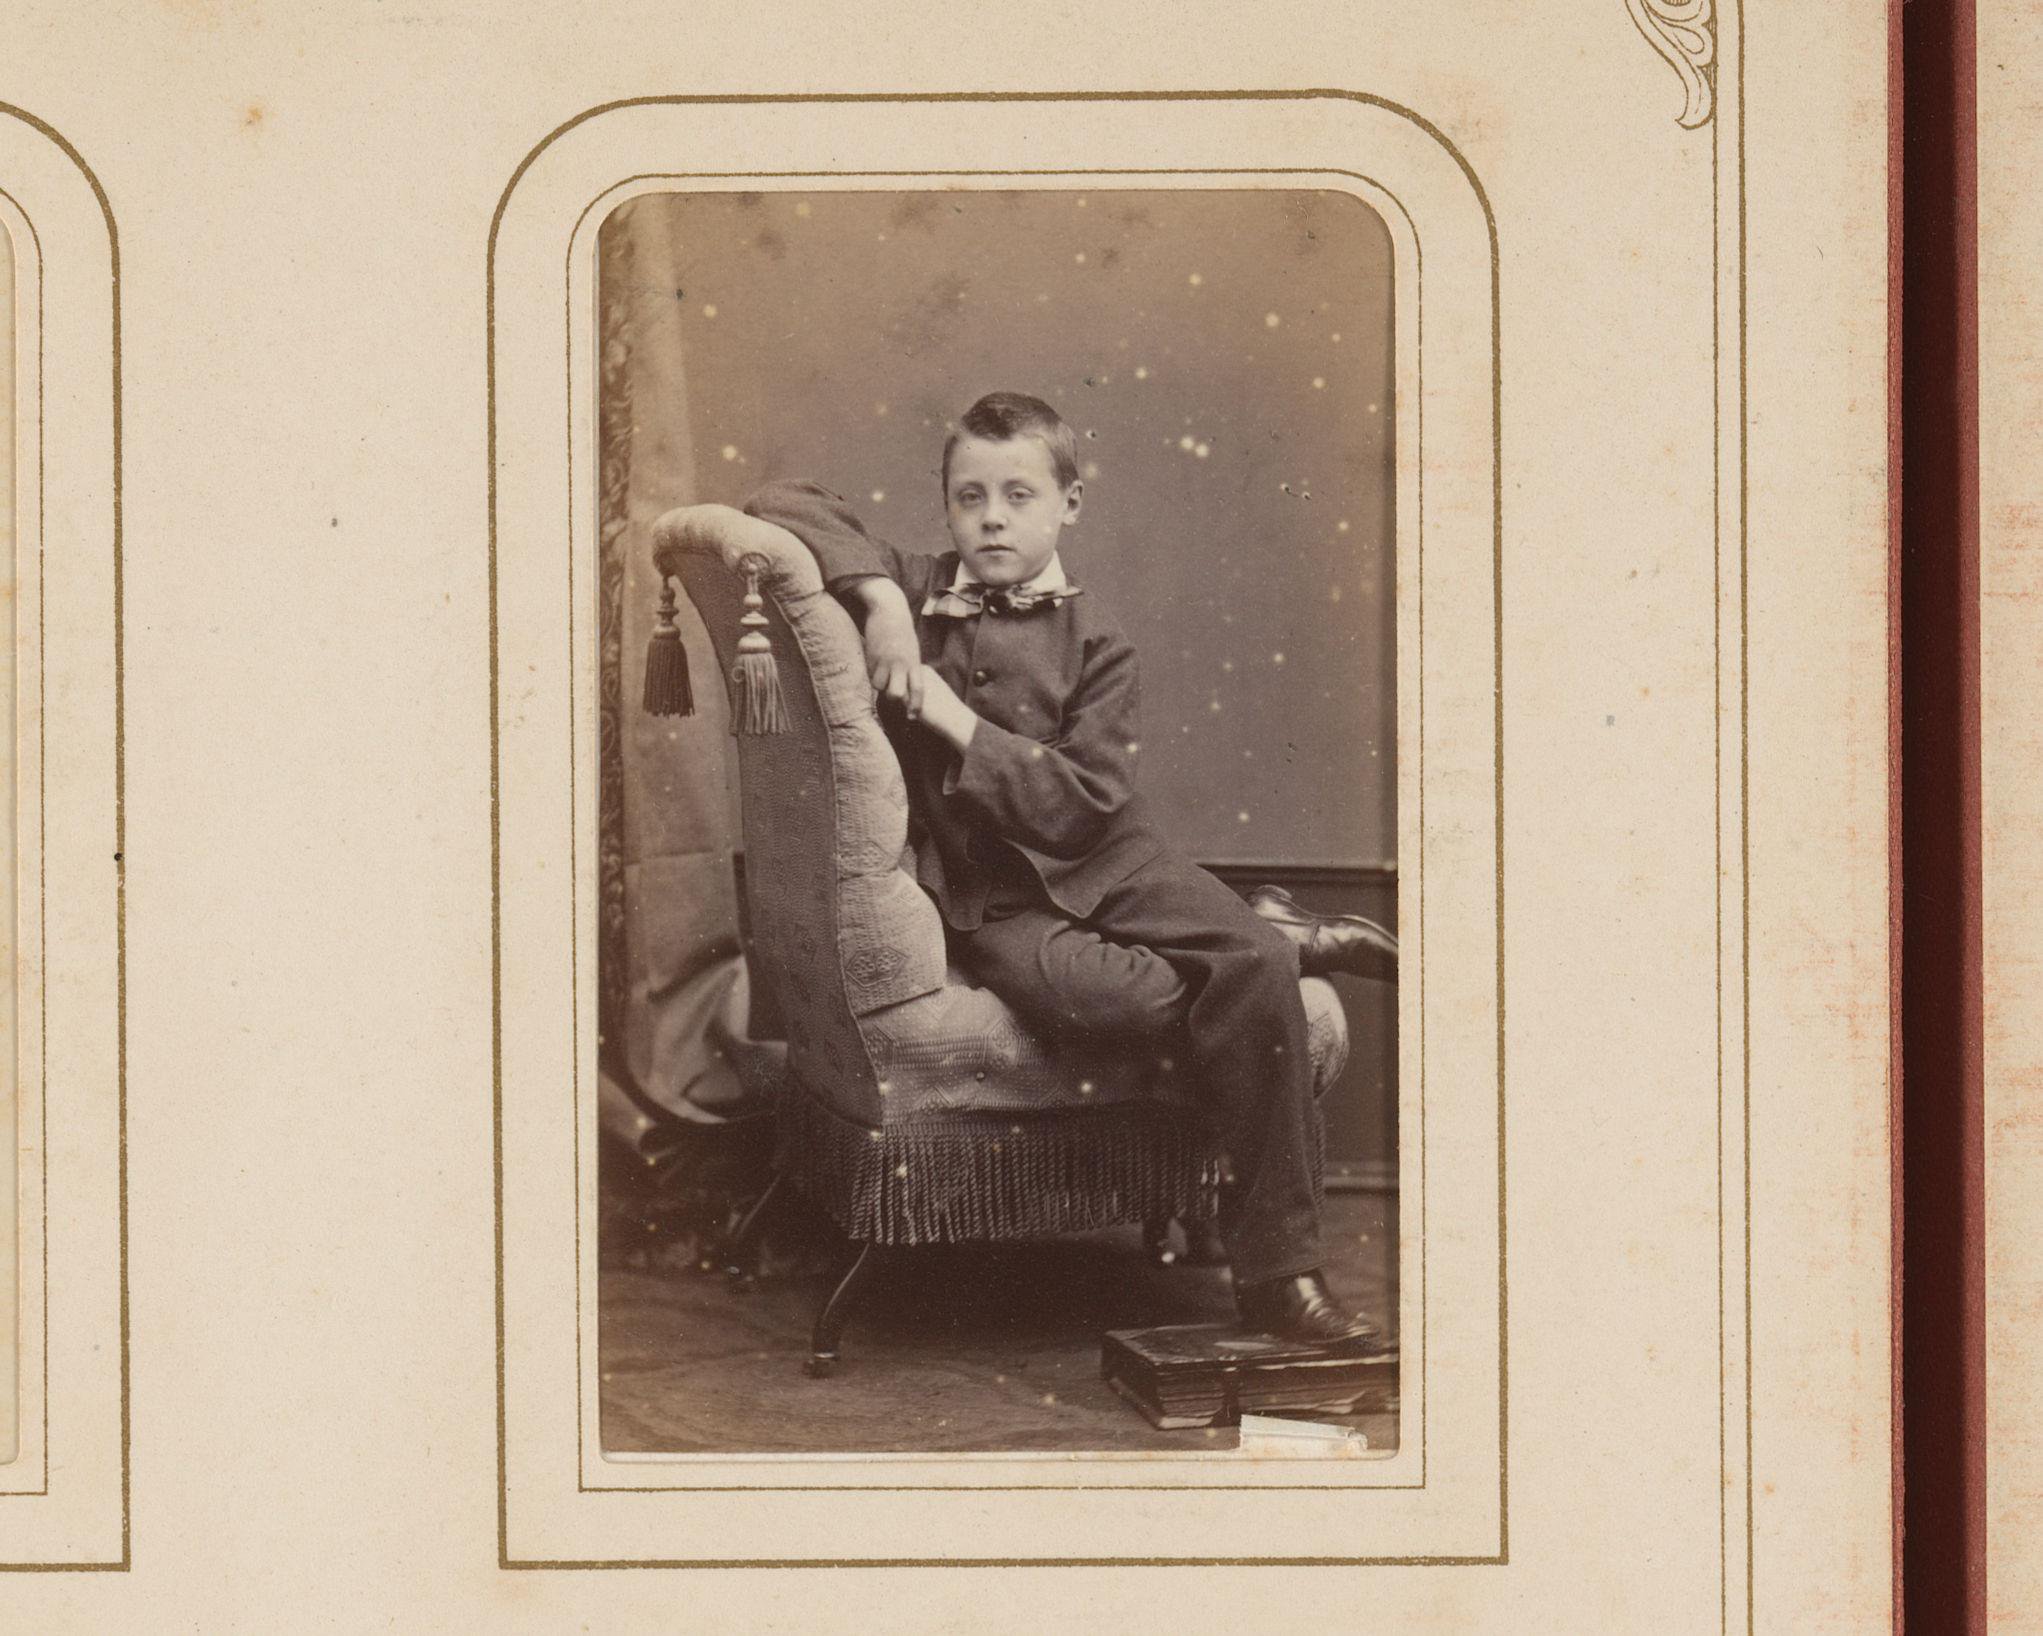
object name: album leaf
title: Portret van een jongen op een stoel, met een album onder zijn voet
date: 1865-1900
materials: cardboard, photographic support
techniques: albumen print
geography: amsterdam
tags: boy (child between toddler and youth), historical persons, chair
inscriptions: inscription: ‘PHOTOGr ATELIER/ WEGNER & MOTTU,/ KALVERSTRAAT/ Over den Heyligenweg D. 26/ AMSTERDAM’